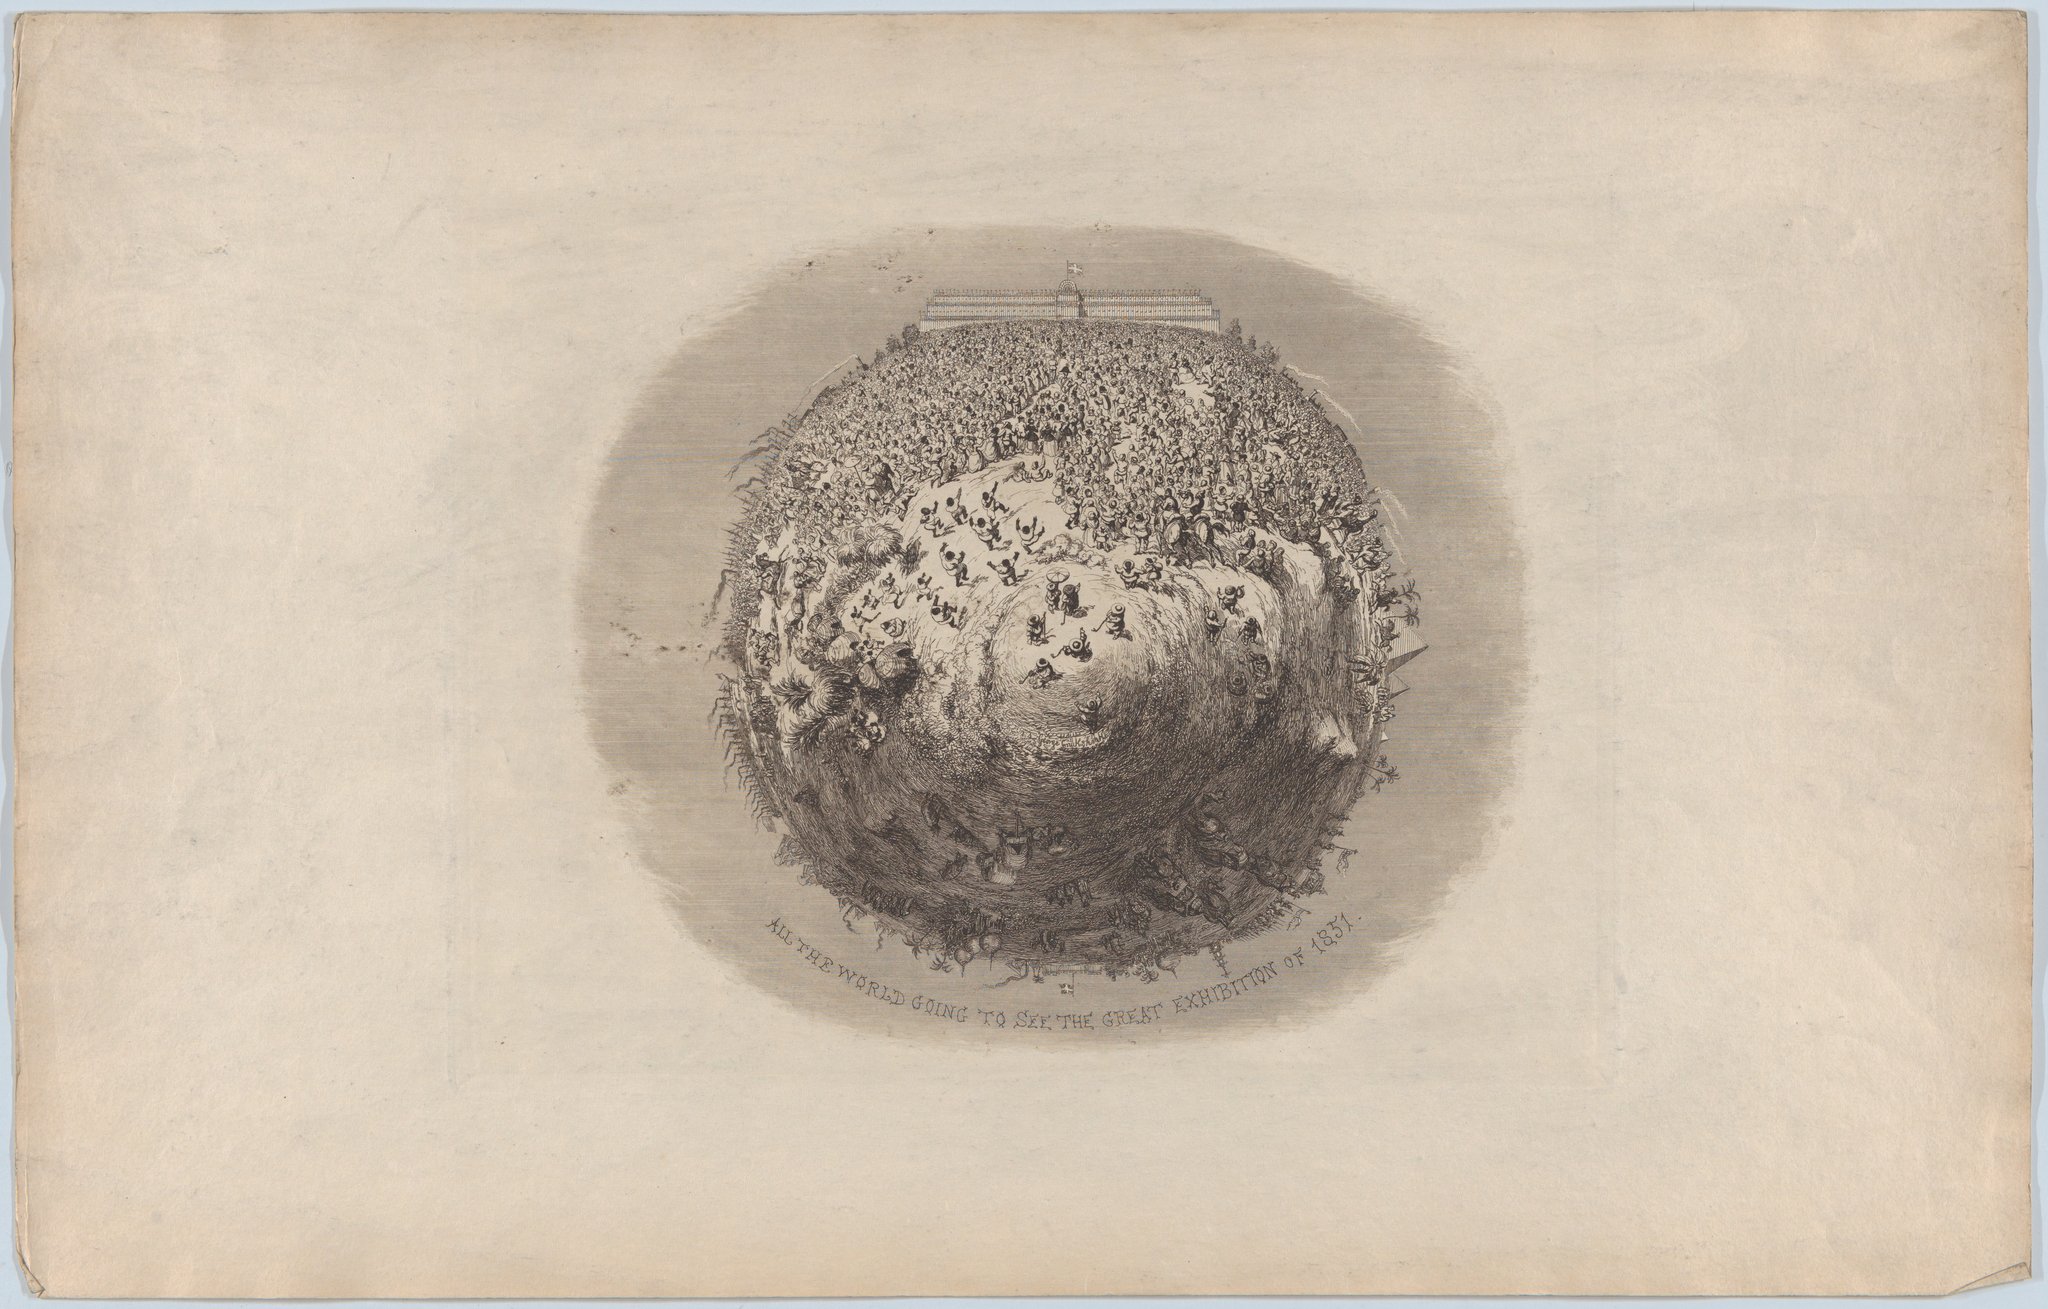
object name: print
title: All the World is Going to See the Great Exhibition of 1851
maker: george cruikshank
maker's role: artist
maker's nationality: british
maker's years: 1792-1878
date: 1851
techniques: etching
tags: crowd,flags